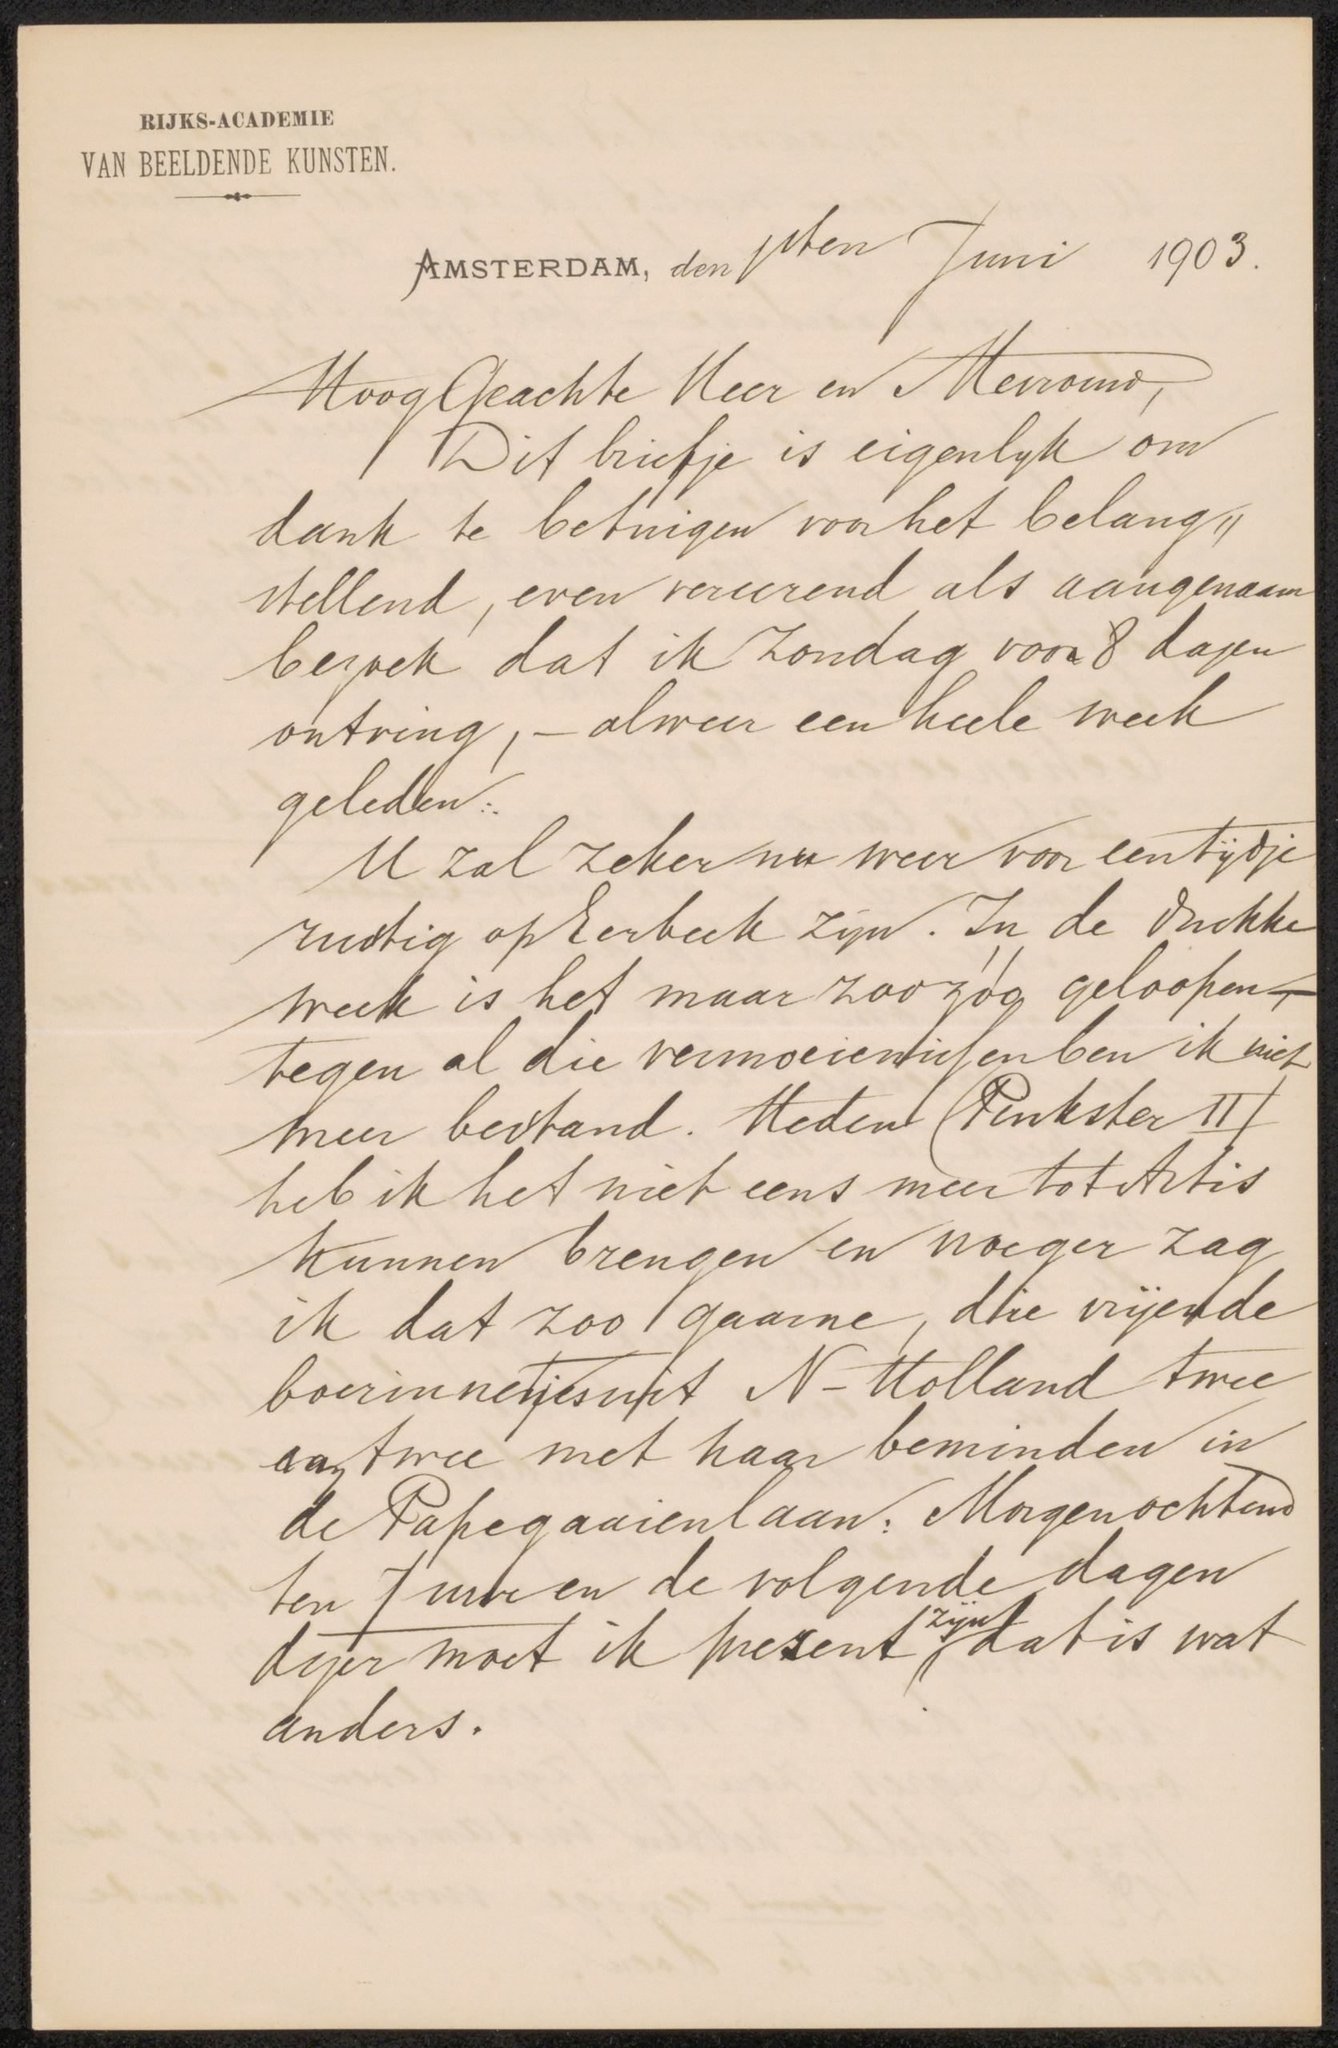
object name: letter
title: Brief aan Max Wilhelm Carl Weber en Anne Antoinette Weber-Van Bosse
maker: august allebé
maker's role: draughtsman, print maker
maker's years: 1838-1927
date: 1903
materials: ink, paper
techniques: pen, printing, writing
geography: amsterdam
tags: anne antoinette weber-van bosse, paris, print maker, draughtsman, jean auguste dominique ingres, criticizing and discussing art, art criticism